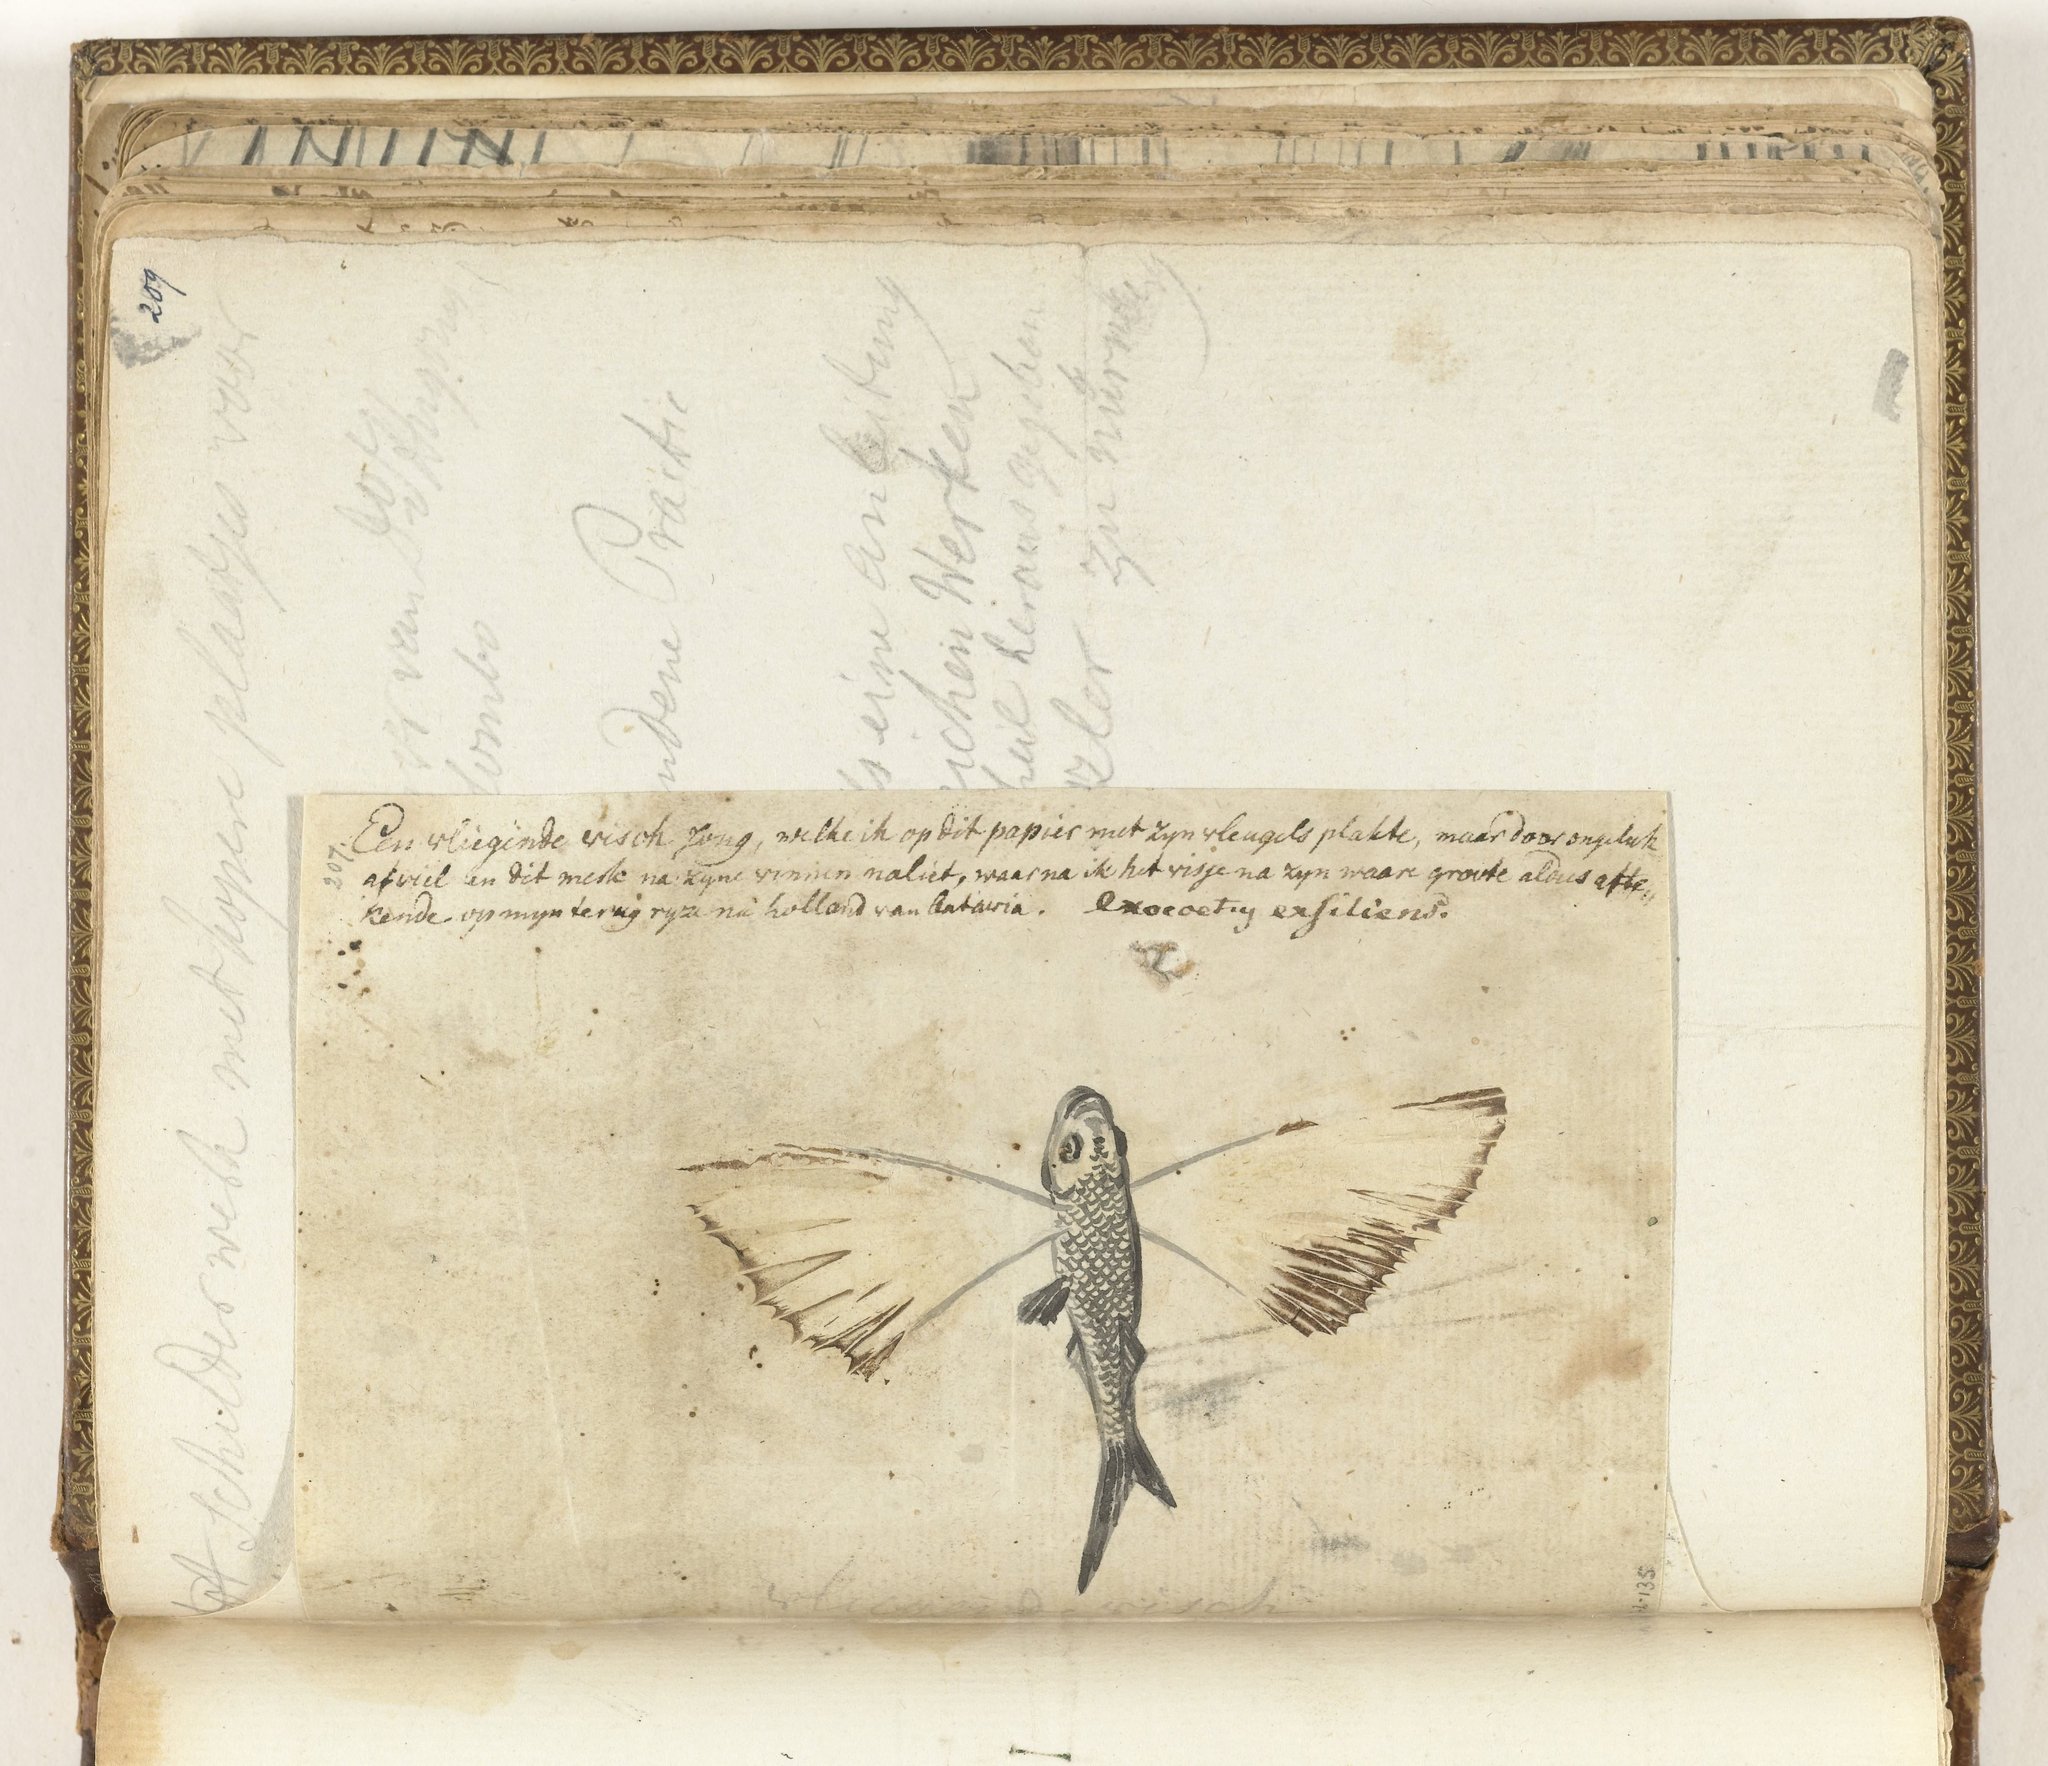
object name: drawing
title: Vliegende vis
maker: jan brandes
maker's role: draughtsman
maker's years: 1743-1808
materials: ink, paper, pencil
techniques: brush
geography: atlantic ocean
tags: bony fishes: flying fish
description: Penseeltekening van een vliegende vis op ware grootte. Met opschrift. Onderdeel uit het schetsboek van Jan Brandes, dl. 2 (1808), p. 207.